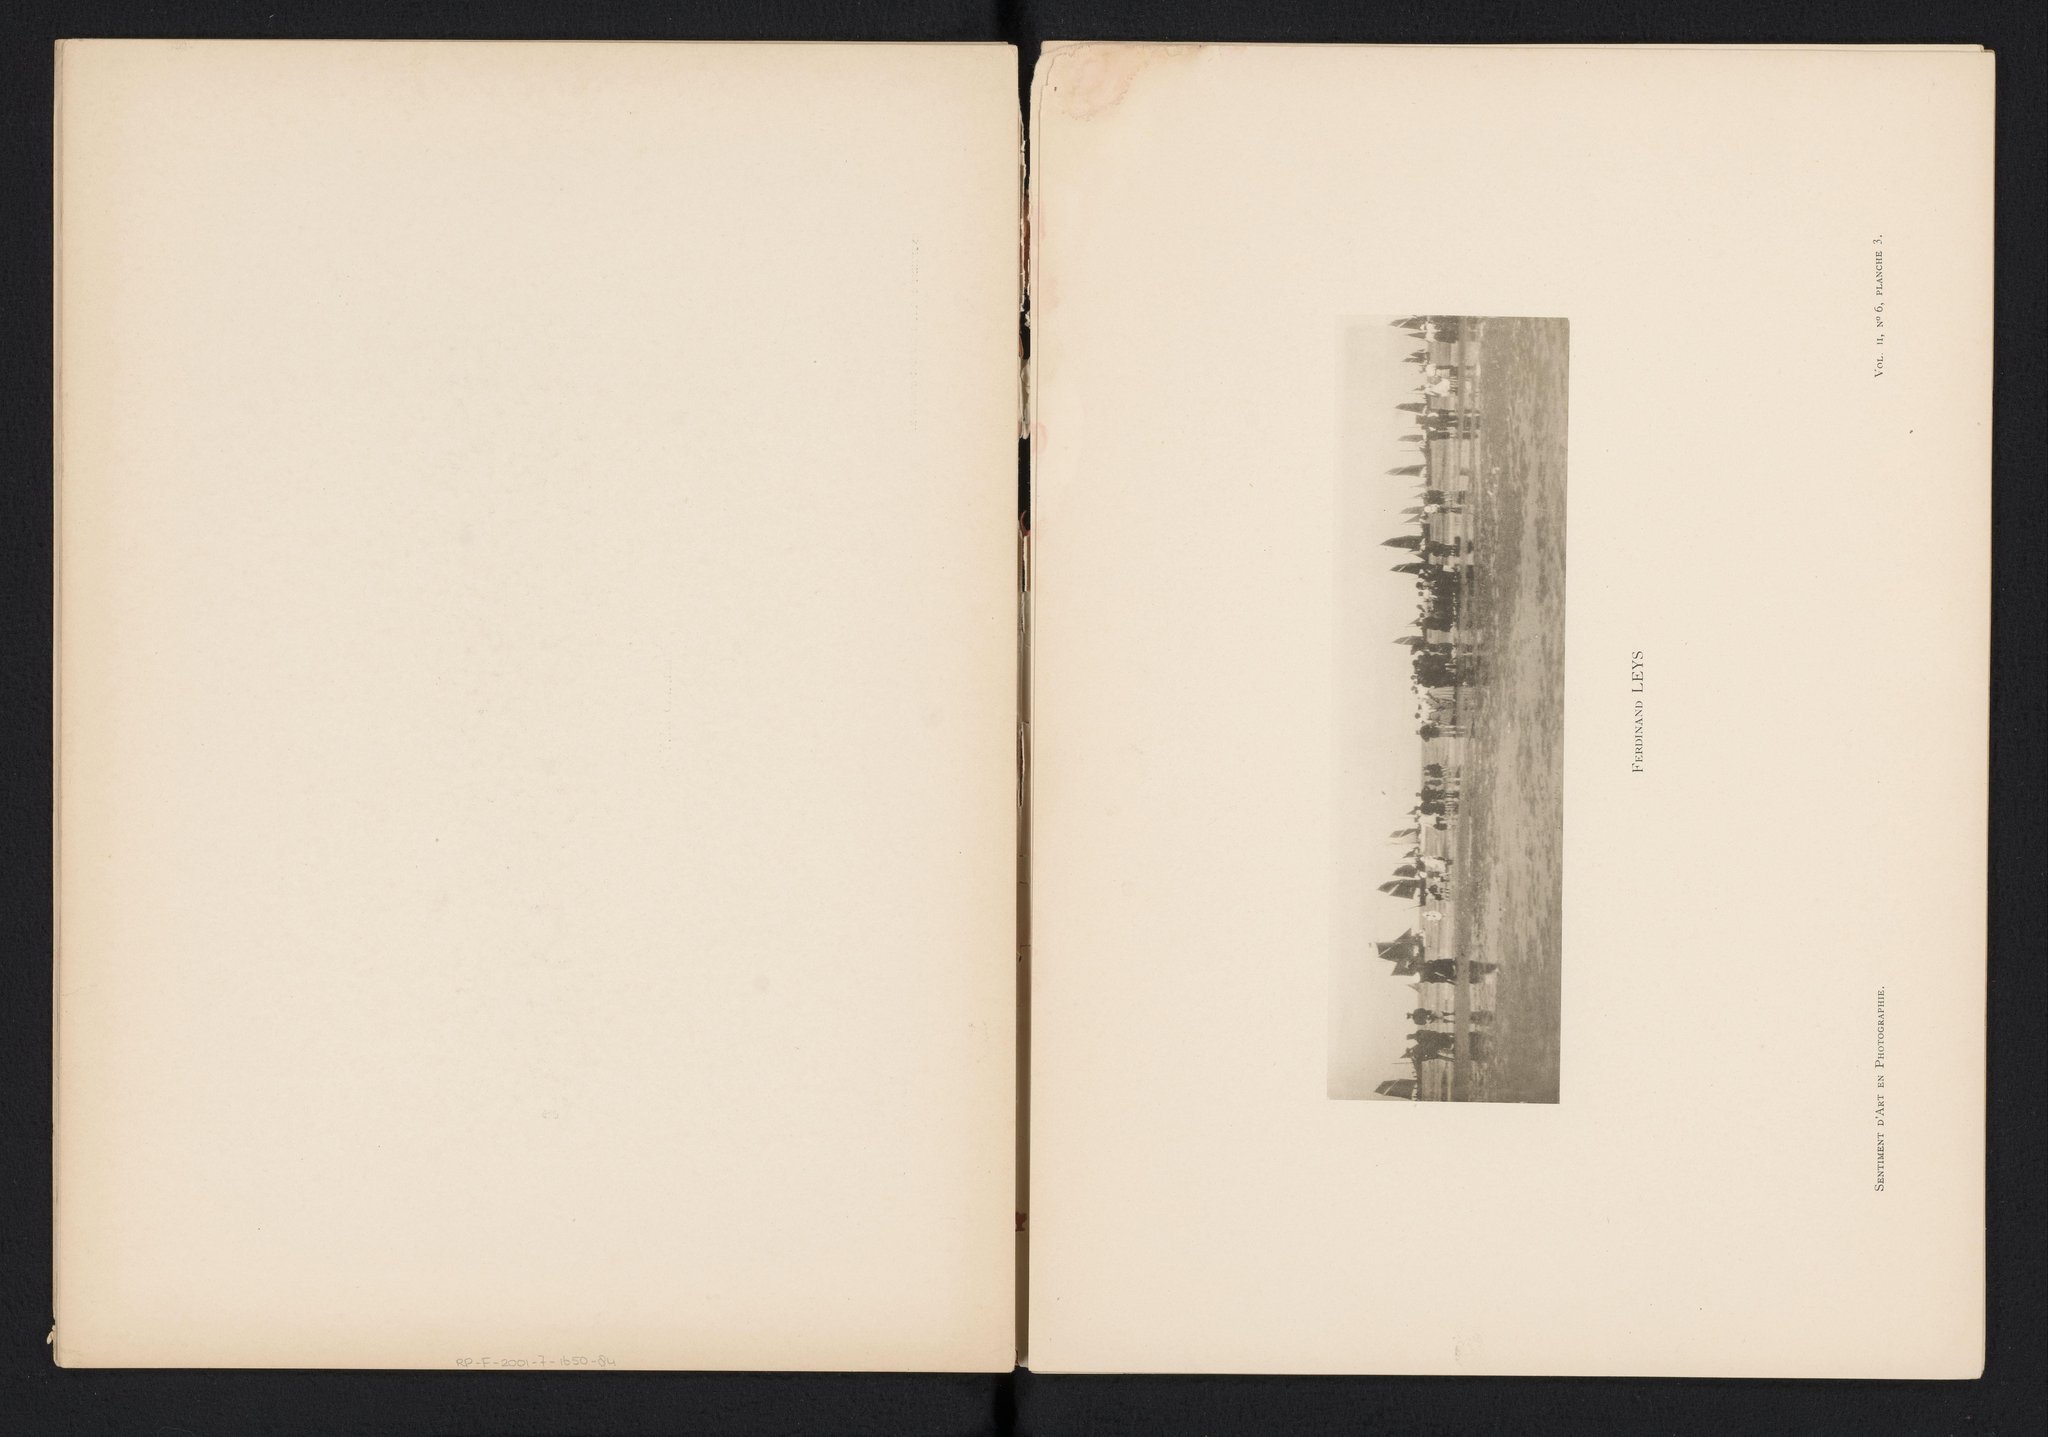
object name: photomechanical print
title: Groep mensen kijkt vanaf het strand naar zeilschepen op zee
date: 1895-1900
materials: paper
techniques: photograph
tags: sailing-ship, sailing-boat, beach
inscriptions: number: ‘Vol. II, No 6, Planche 3.’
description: Deze prent maakt deel uit van 8 omslagen met 22 tekstbladen en 89 prenten op losse bladen in en tussen de omslagen.